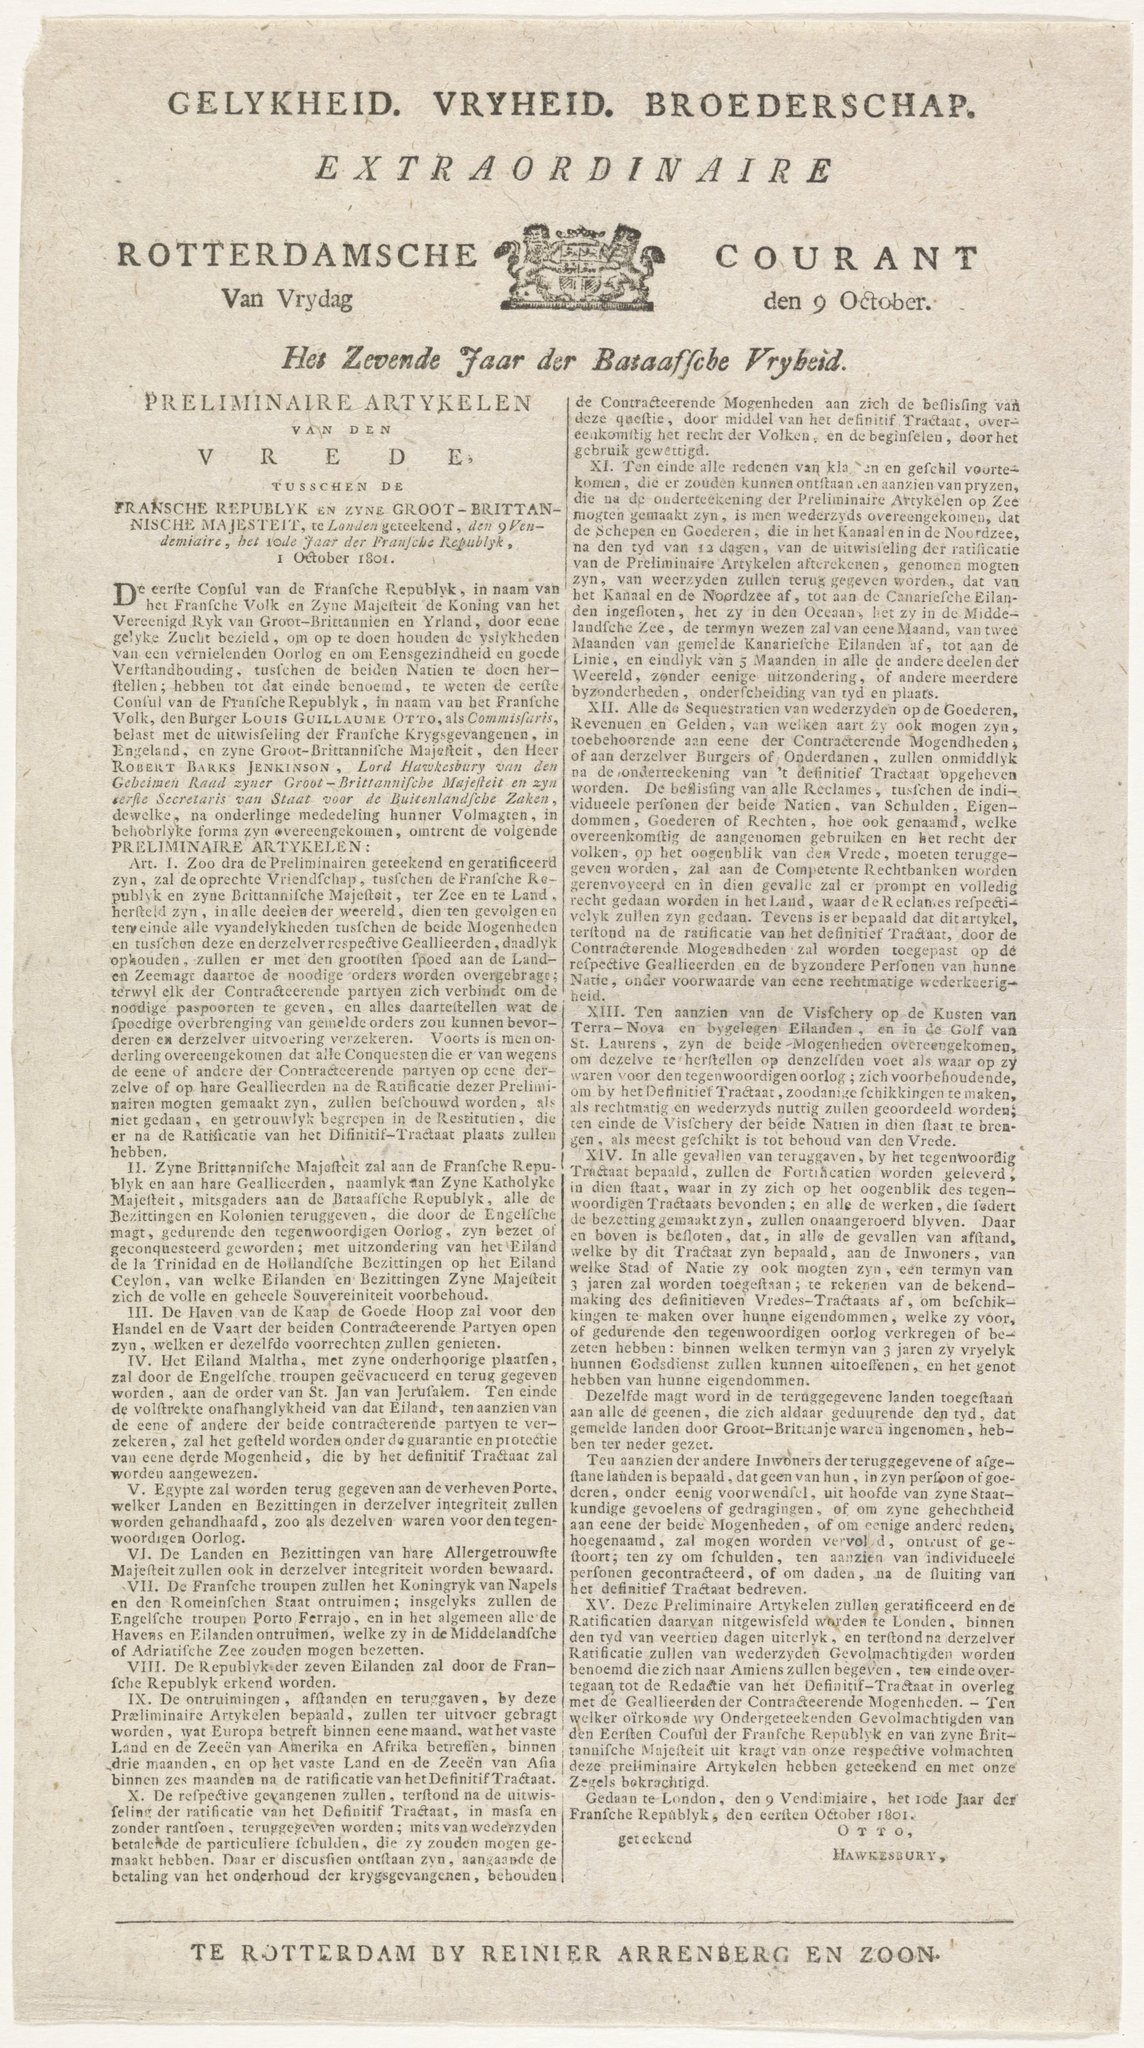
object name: newspaper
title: Extraordinaire Rotterdamsche Courant van Vrydag den 9 October. Het Zevende Jaar der Bataafsche Vryheid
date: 1801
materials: paper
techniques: letterpress printing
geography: rotterdam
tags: london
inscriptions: collector's mark: Lugt 2228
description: Extraordinaire Rotterdamsche Courant van vrijdag 9 oktober 1801 waarin de preliminaire artikelen van de vrede die in Londen op 1 oktober 1801 is bereikt tussen Frankrijk en Groot-Brittannië.